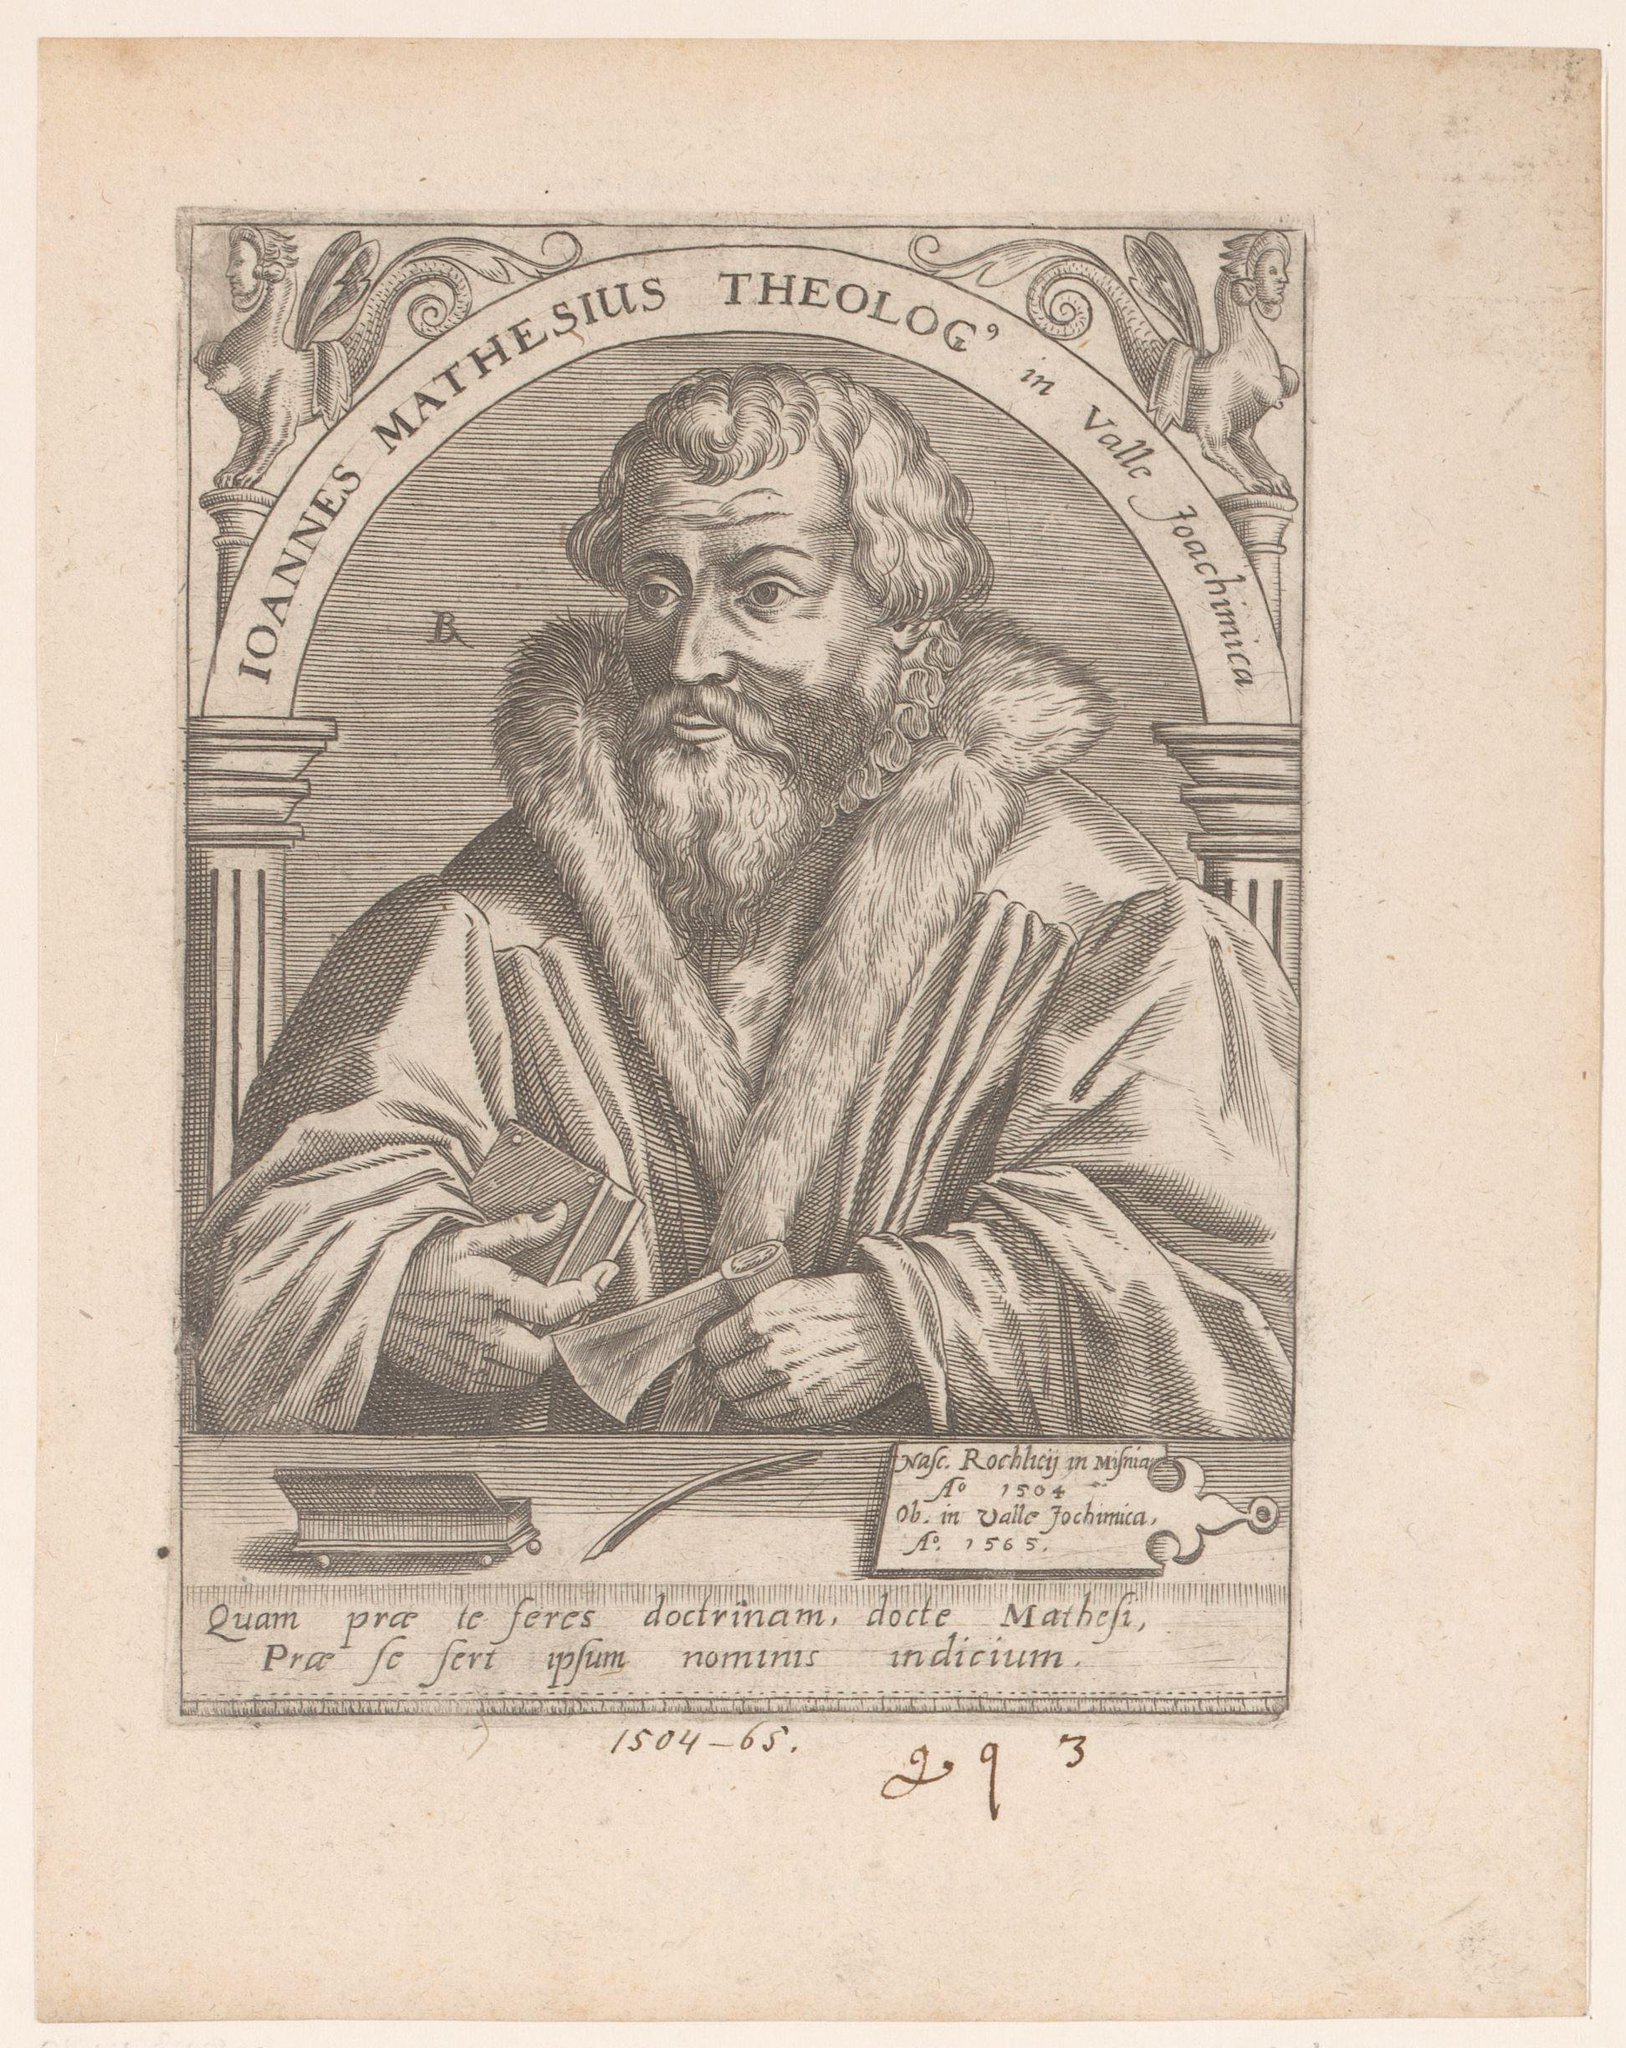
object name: print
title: Portret van Johannes Mathesius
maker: robert boissard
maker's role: print maker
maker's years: 1570-1611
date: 1597-1599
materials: paper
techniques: engraving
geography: france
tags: historical persons, book, harpy (fabulous bird); 'arpie' (ripa)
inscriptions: inscription: ‘1504-65. Q q 3’, collector's mark: Lugt 2228